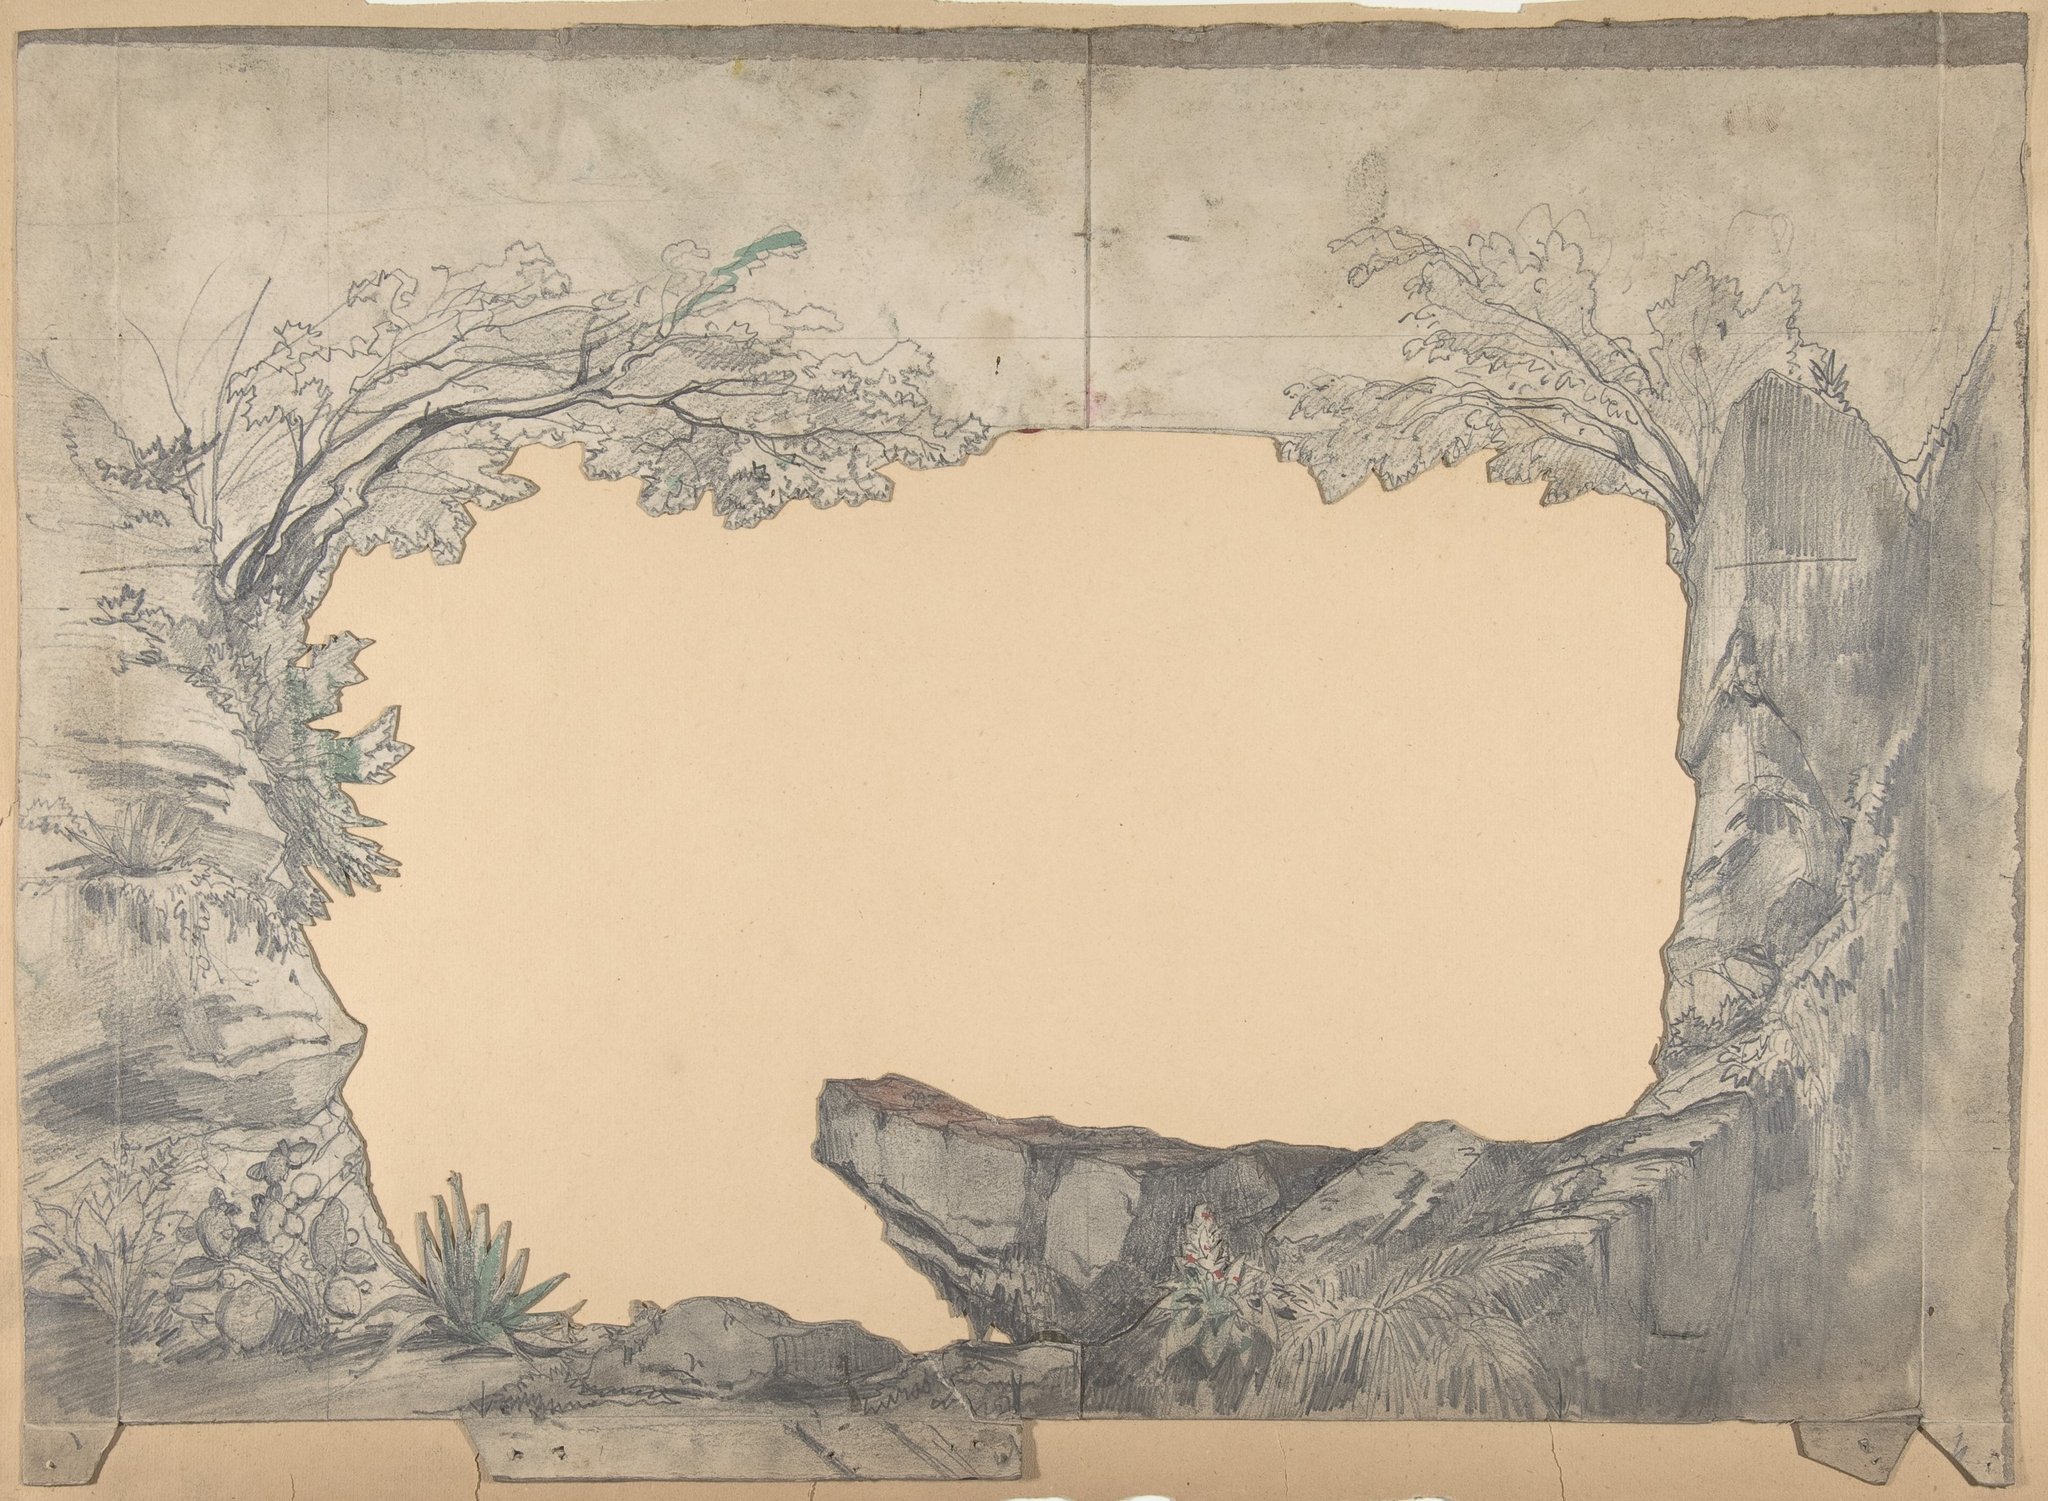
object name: drawing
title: Design for a Stage Set at the Opéra, Paris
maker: eugène cicéri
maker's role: artist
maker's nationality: french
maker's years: 1813-1890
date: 1830-1890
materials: gouache, graphite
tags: trees,stage design